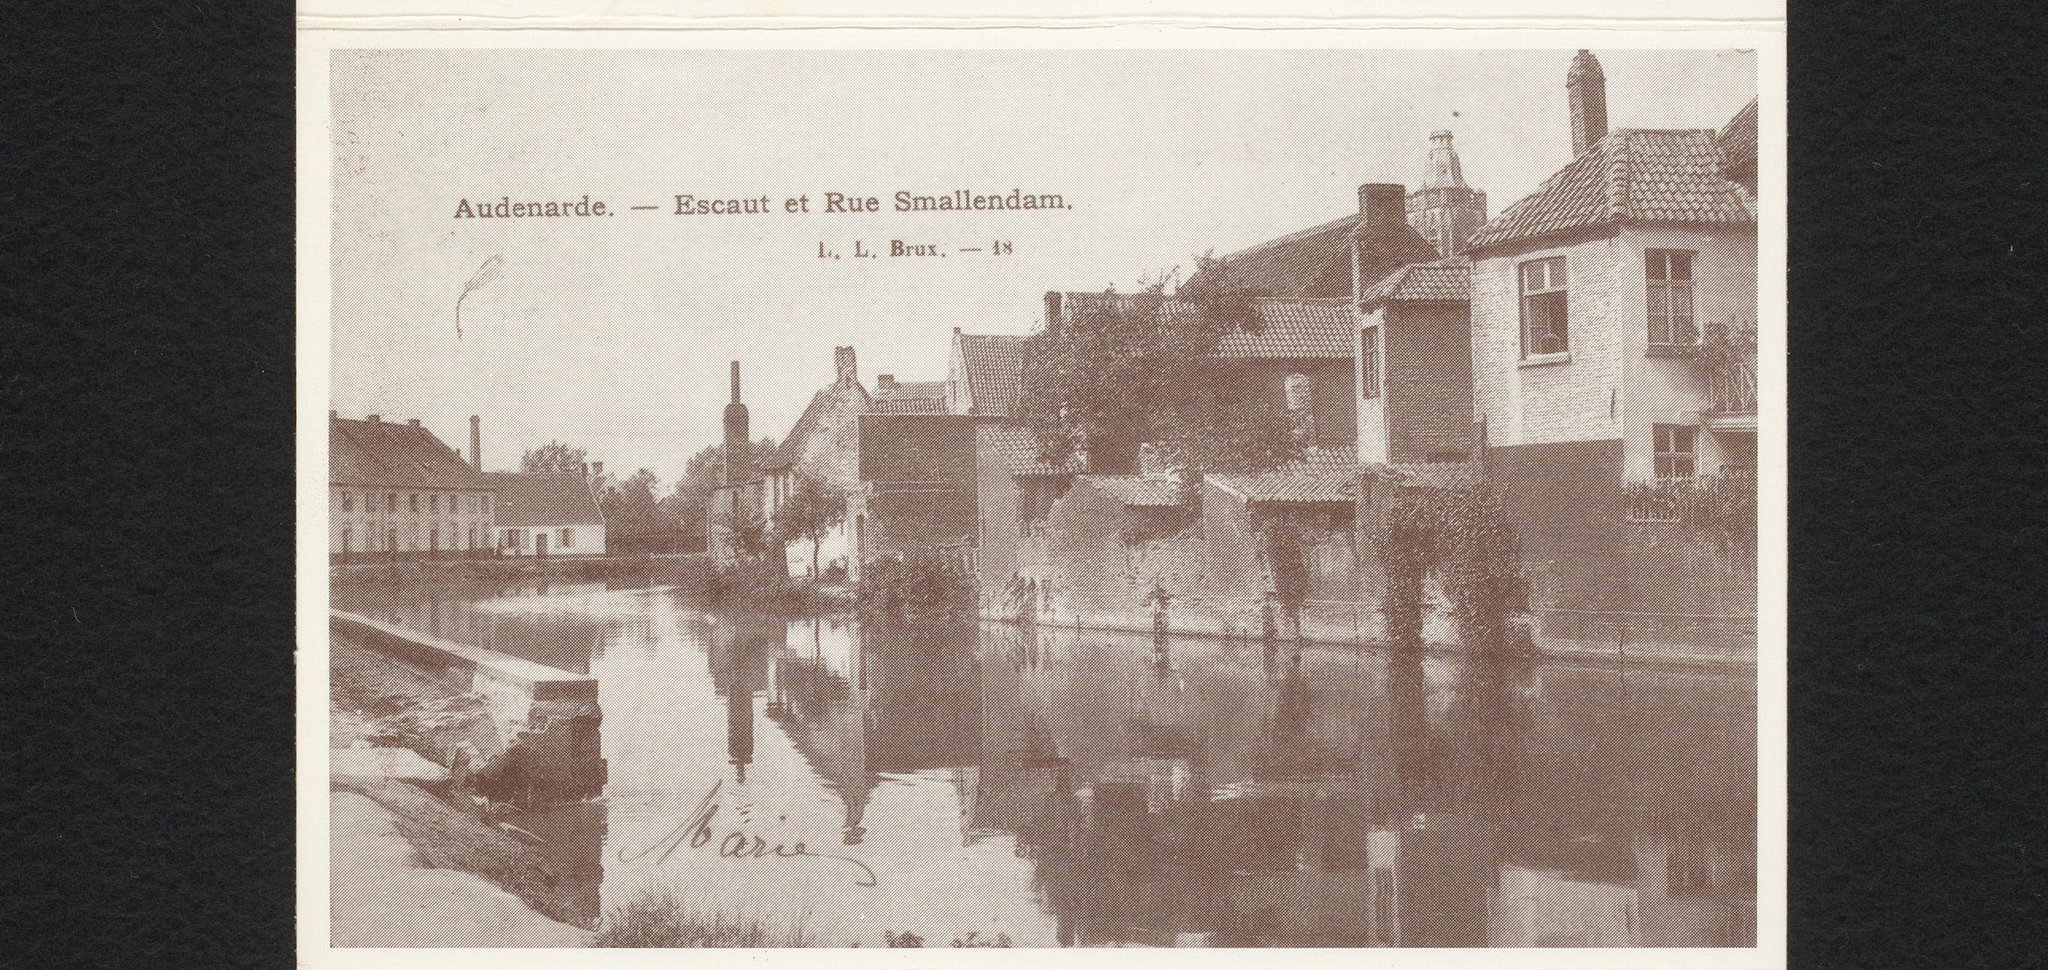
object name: reproduction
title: Audenarde. Escaut et Rue Smallendam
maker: Anonymous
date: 1981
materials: cardboard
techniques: offset printed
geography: oudenaarde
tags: city-view, and landscape with man-made constructions, river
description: Deze prentbriefkaart is een reproductie van een oudere prentbriefkaart.